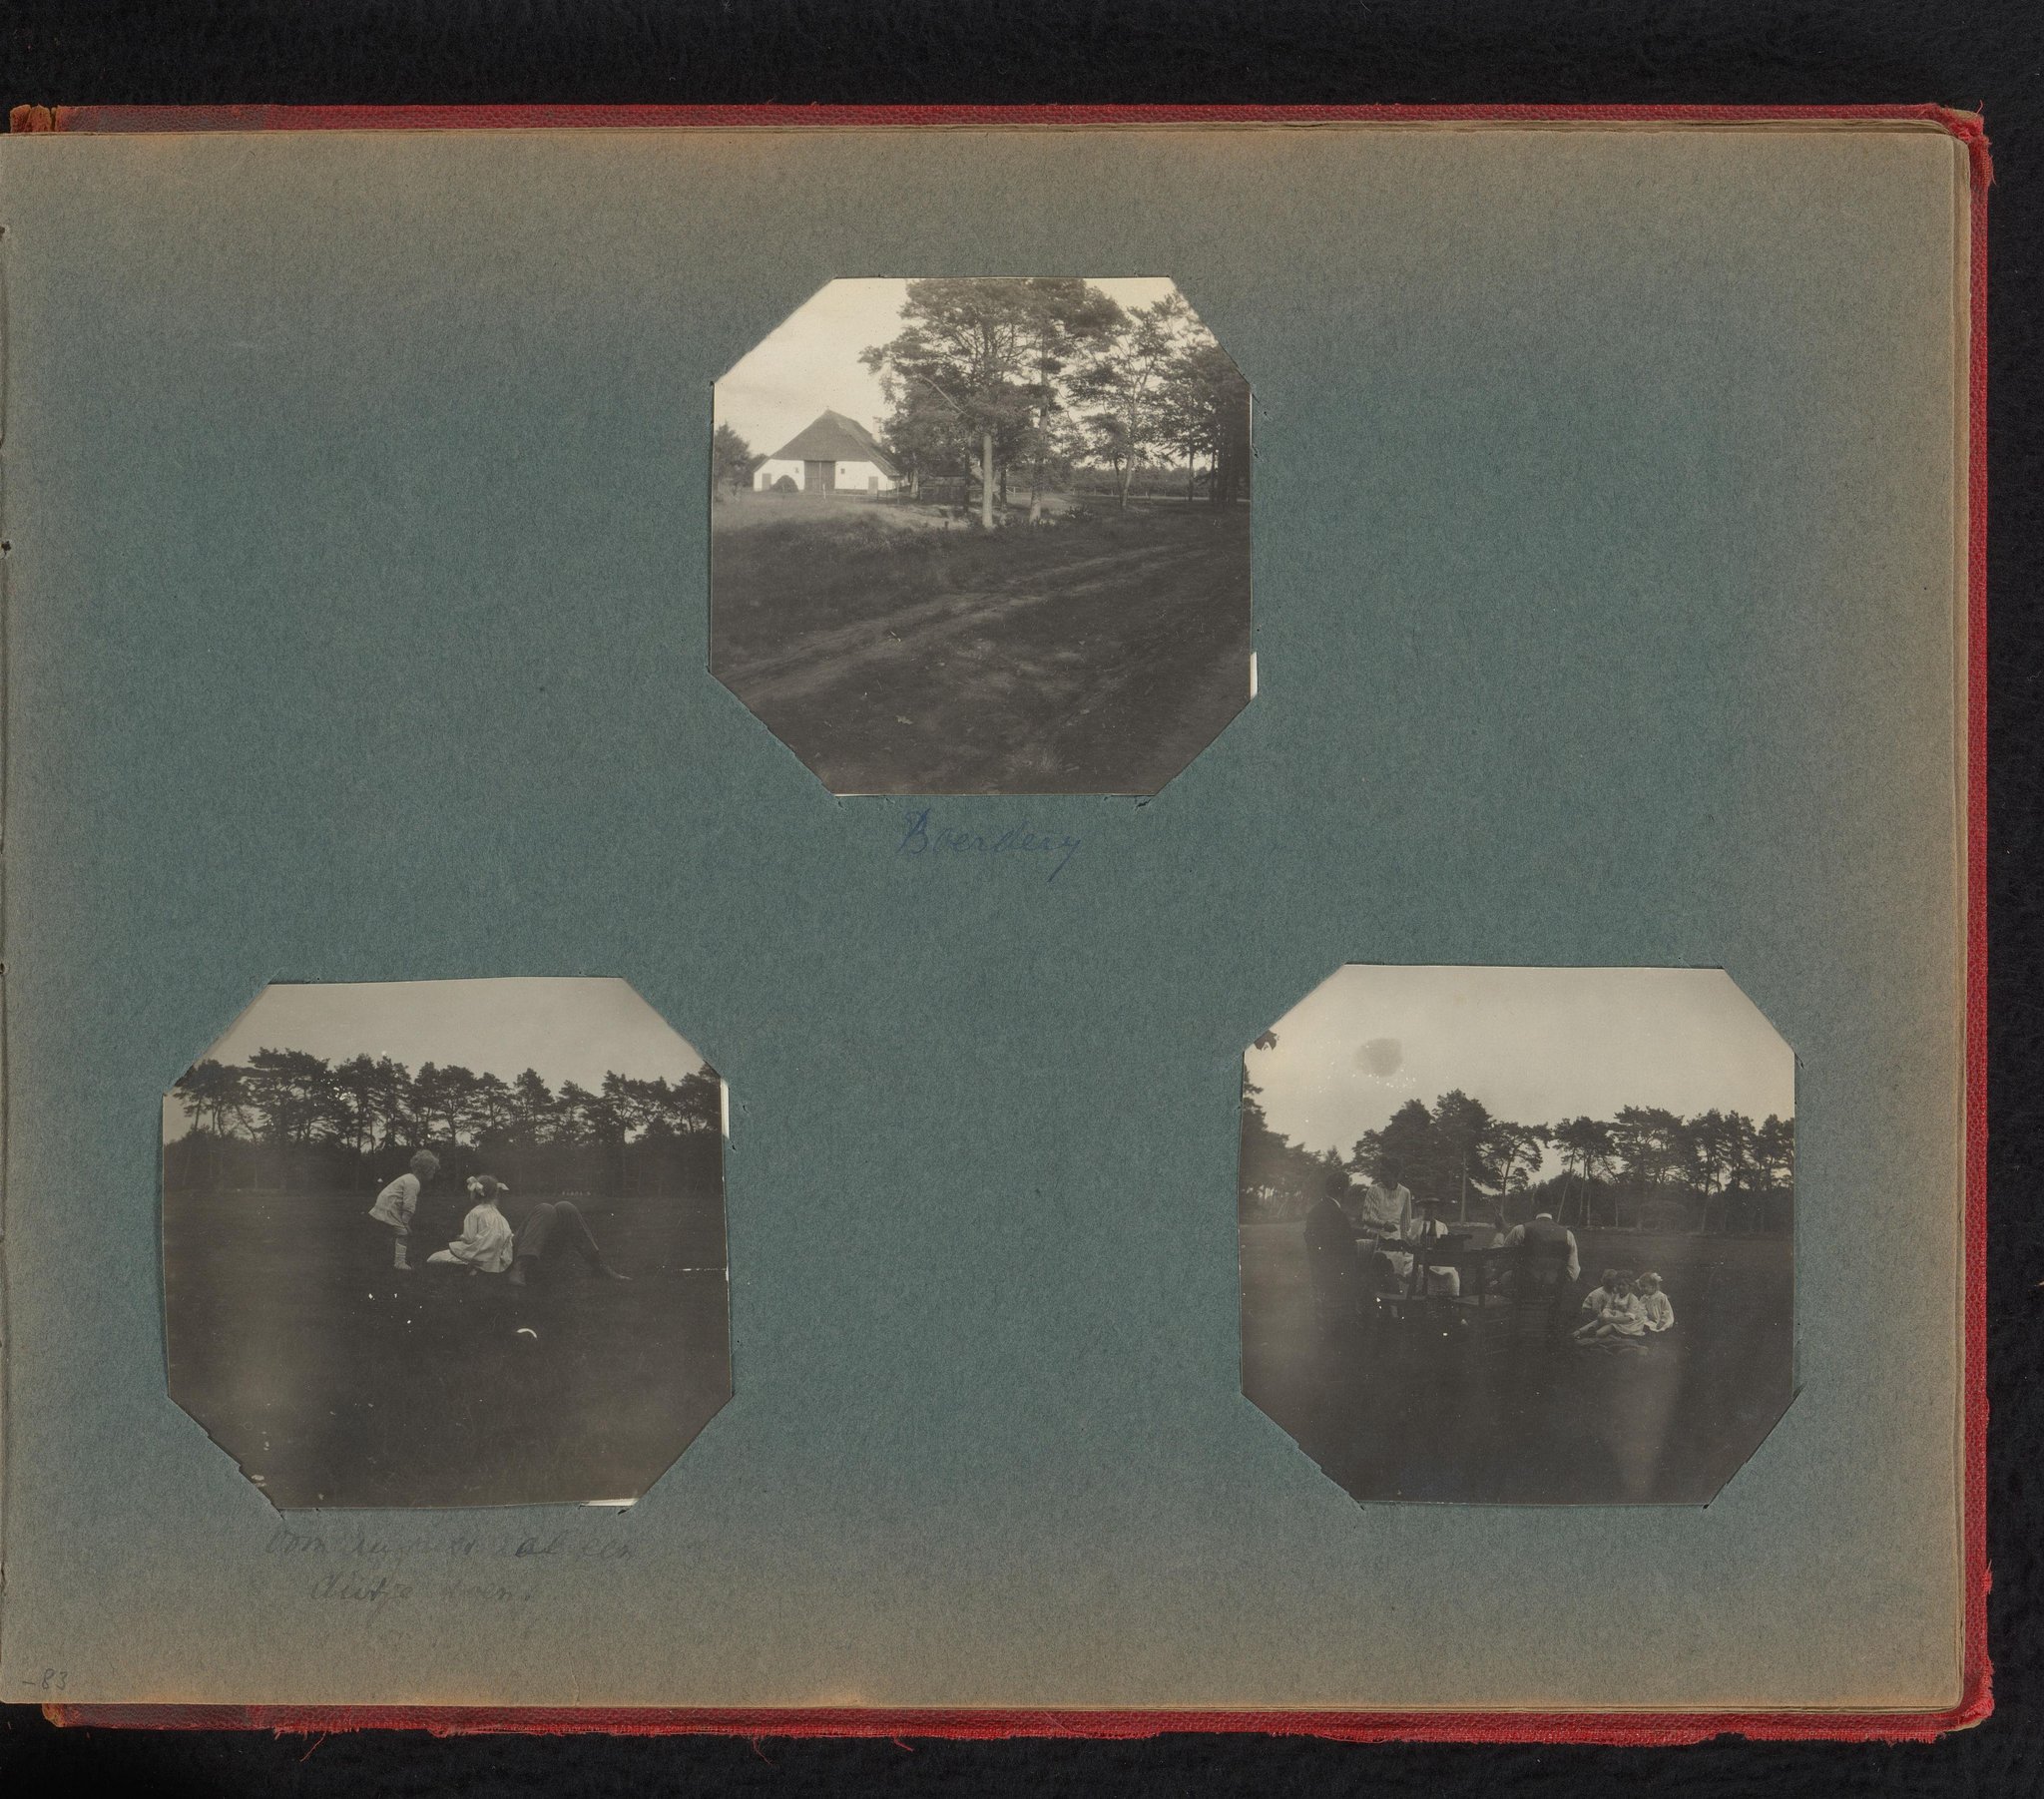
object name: album leaf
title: De familie Matthes, tijdens een familie uitje bij Villa Eperheem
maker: charlotte alida boelen-matthes (lot)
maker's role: amateurfotograaf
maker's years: 1889-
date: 1919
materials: paper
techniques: gelatin silver print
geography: epe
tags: amsterdam, thailand, eva charlotte pennink-boelen, charlotte alida boelen-matthes (lot), joan gerard boelen, family life, villa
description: Deze foto's zijn onderdeel van een album.